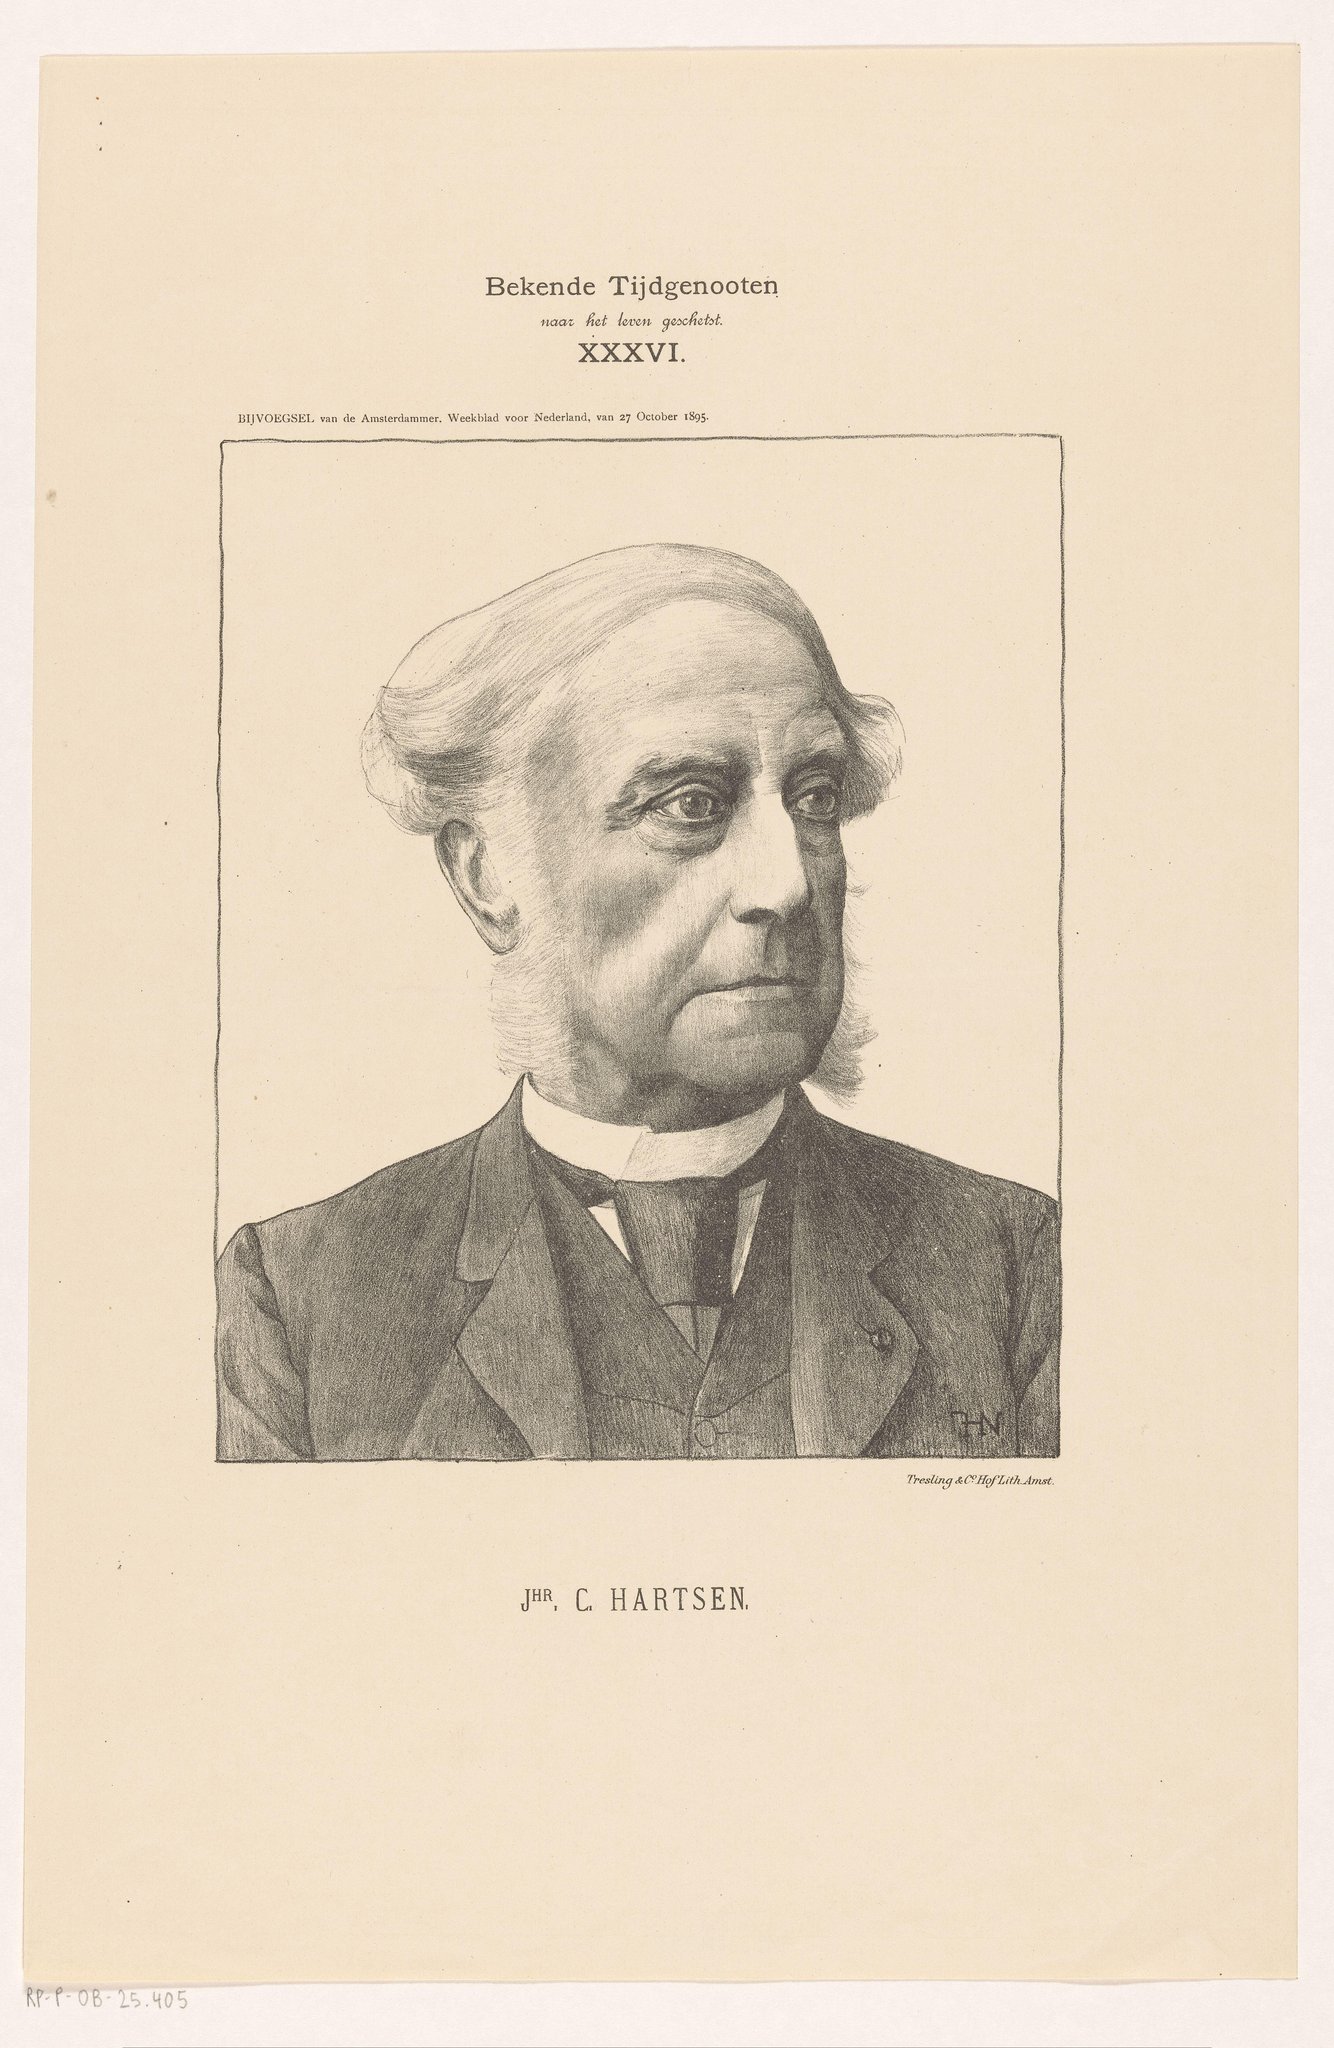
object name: print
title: Bekende tijdgenooten naar het leven geschetst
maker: ferdinand hart nibbrig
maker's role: draughtsman, painter, print maker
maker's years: 1866-1915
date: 1895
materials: paper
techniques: lithograph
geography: amsterdam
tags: amsterdam, historical persons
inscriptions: collector's mark: Lugt 2228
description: Verschenen in het bijvoegsel van 'De Amsterdammer, Weekblad voor Nederland' van 27 oktober 1895.